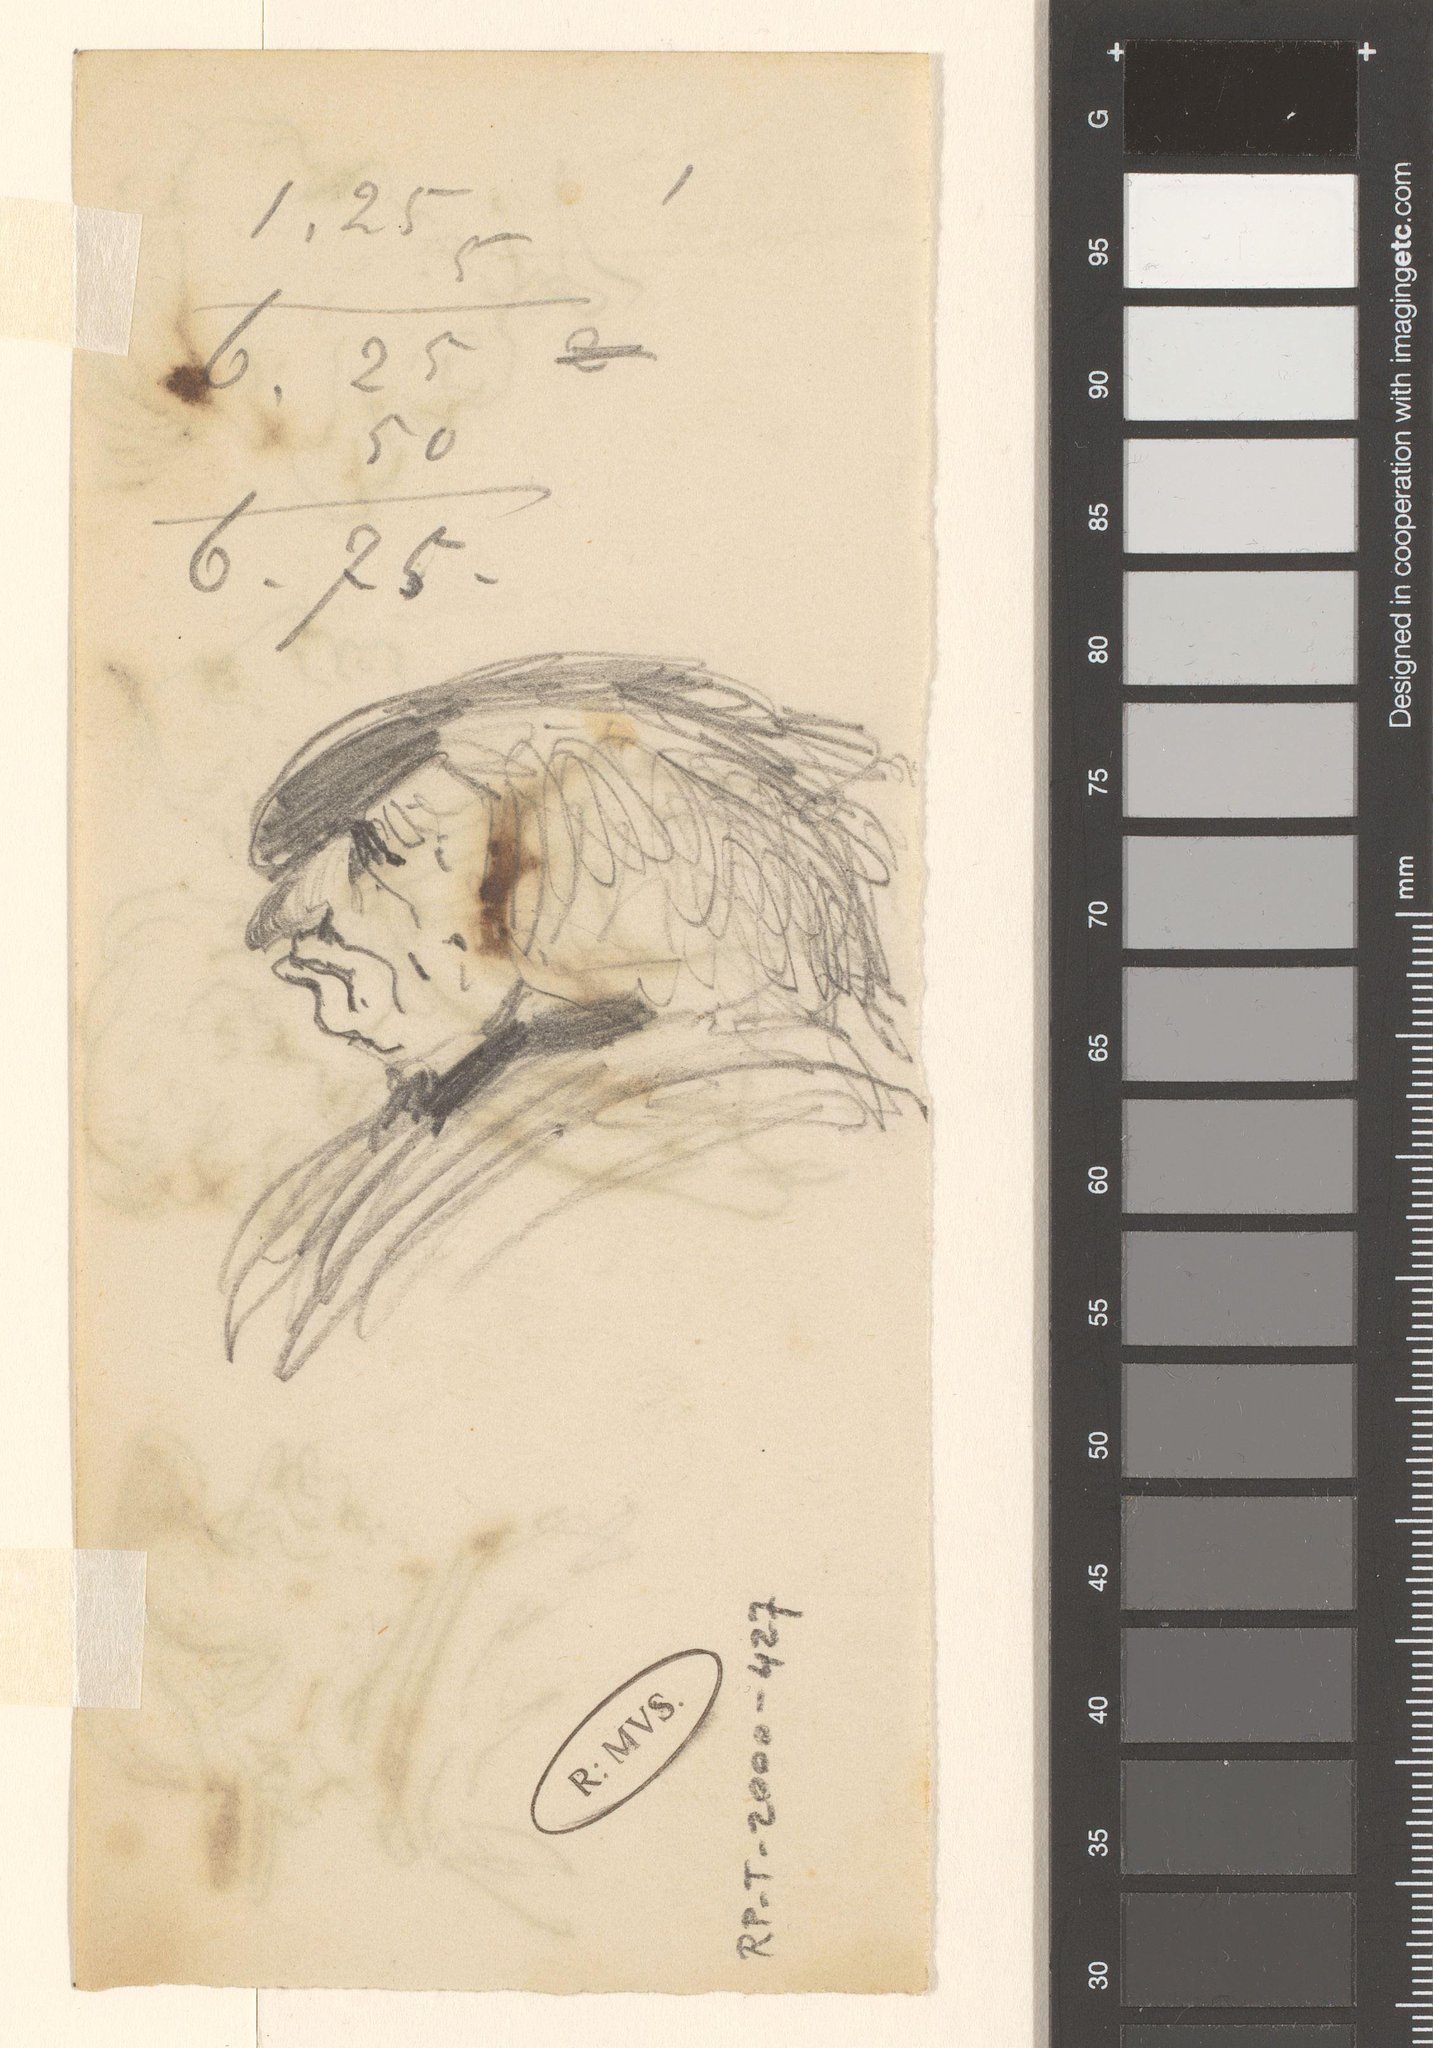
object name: drawing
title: Kop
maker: johannes tavenraat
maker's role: draughtsman, painter, print maker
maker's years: 1809-1881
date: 1840-1880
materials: paper, pencil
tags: caricatures (human types)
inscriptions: collector's mark: Lugt 2228